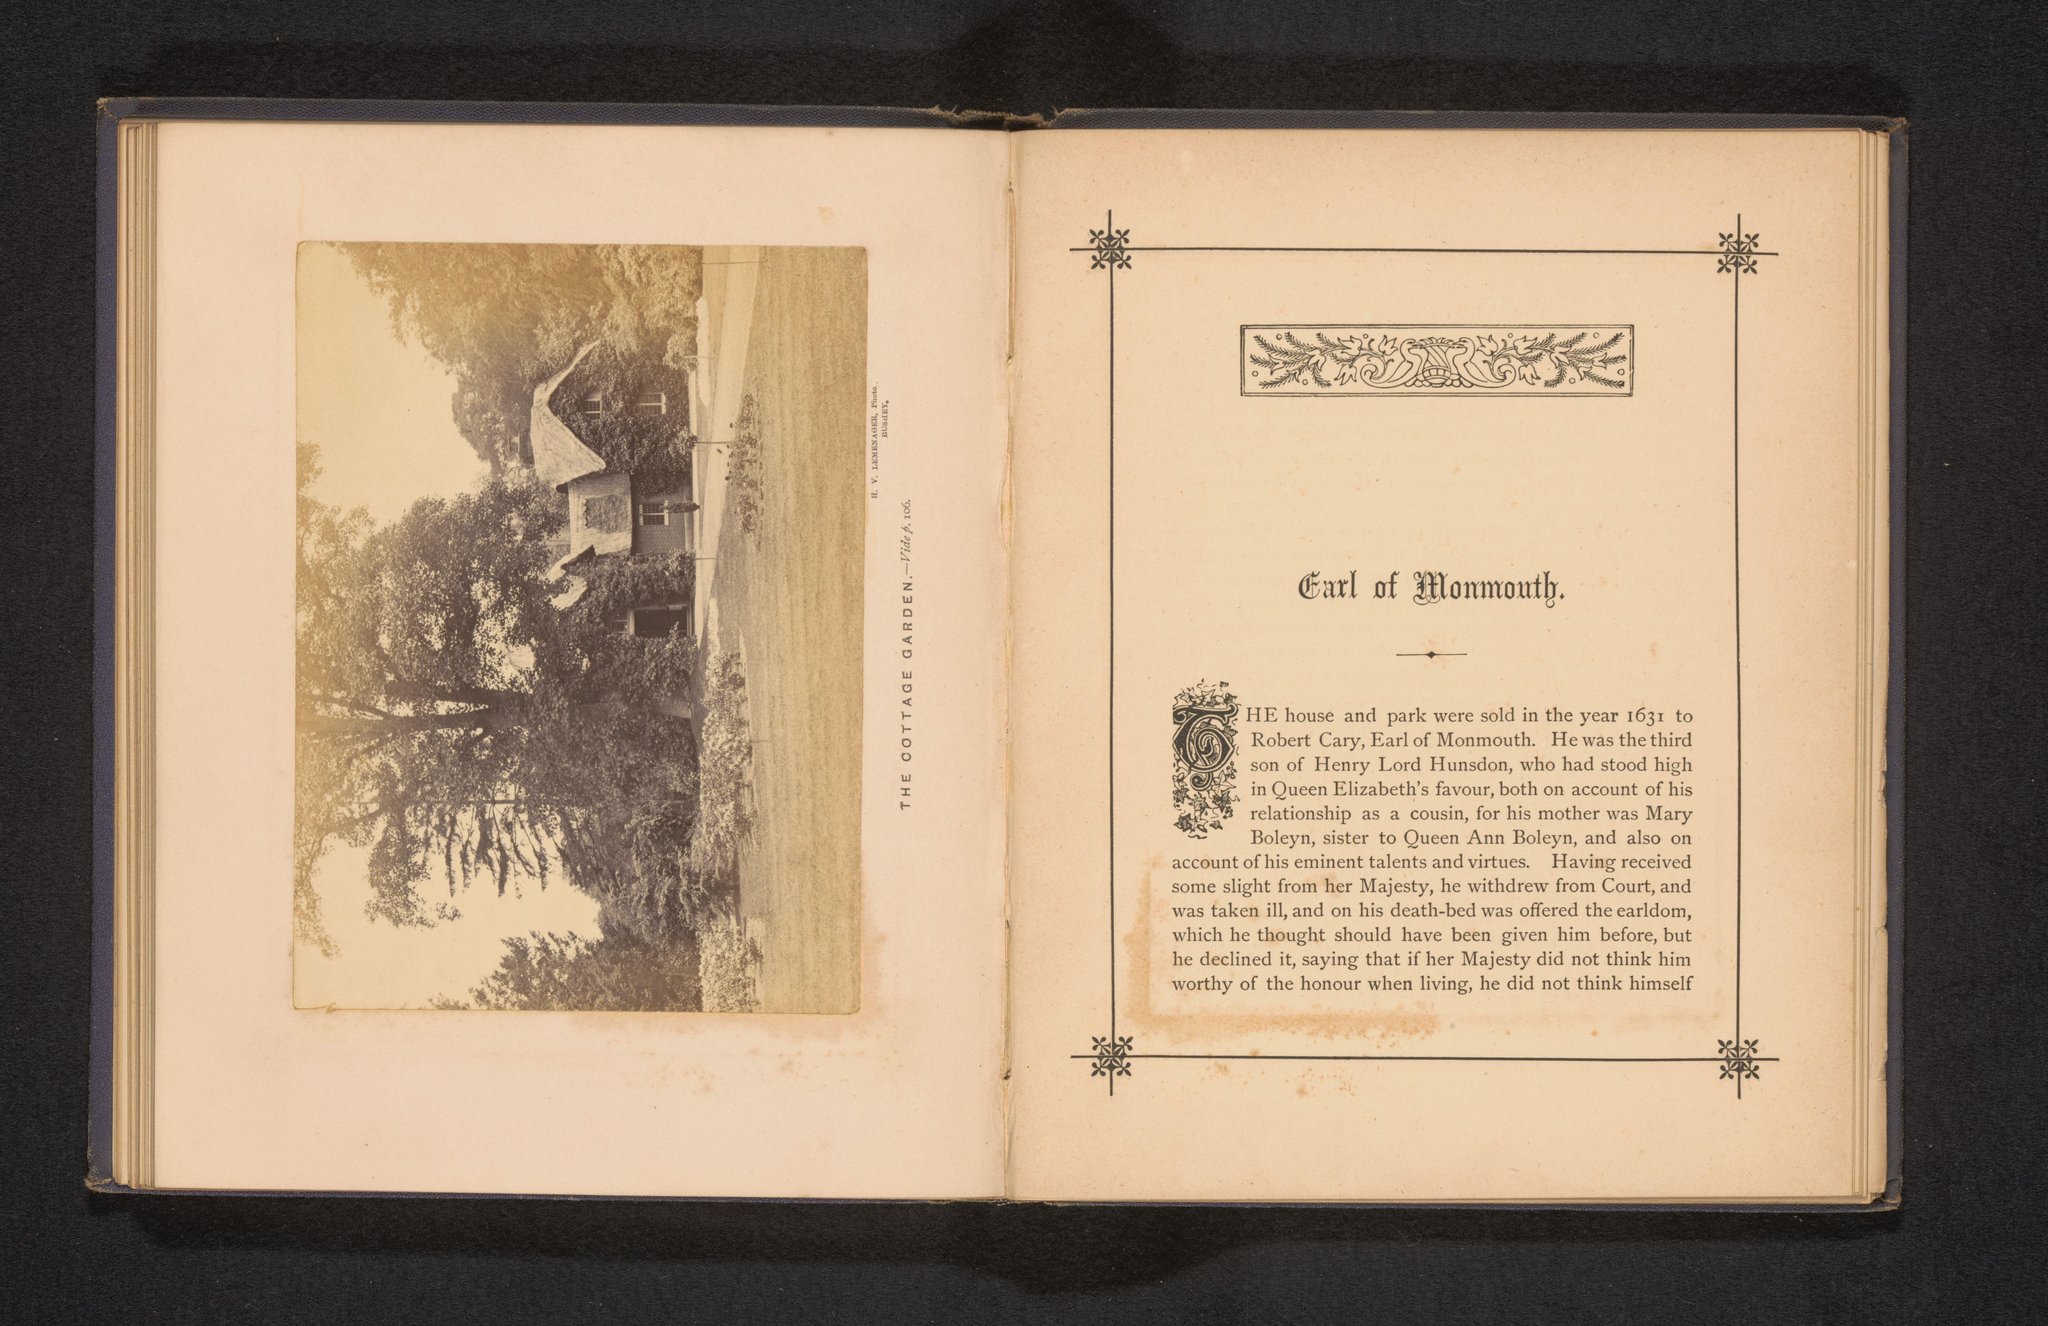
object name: photograph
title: Gezicht op een huis met tuin in Moor Park in Rickmansworth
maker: henri victor leménager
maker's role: docent, fotograaf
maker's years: 1822-1912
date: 1866-1871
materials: photographic support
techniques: albumen print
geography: rickmansworth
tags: cottage, garden approach, garden drive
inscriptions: inscription: ‘Vide p. 106.’